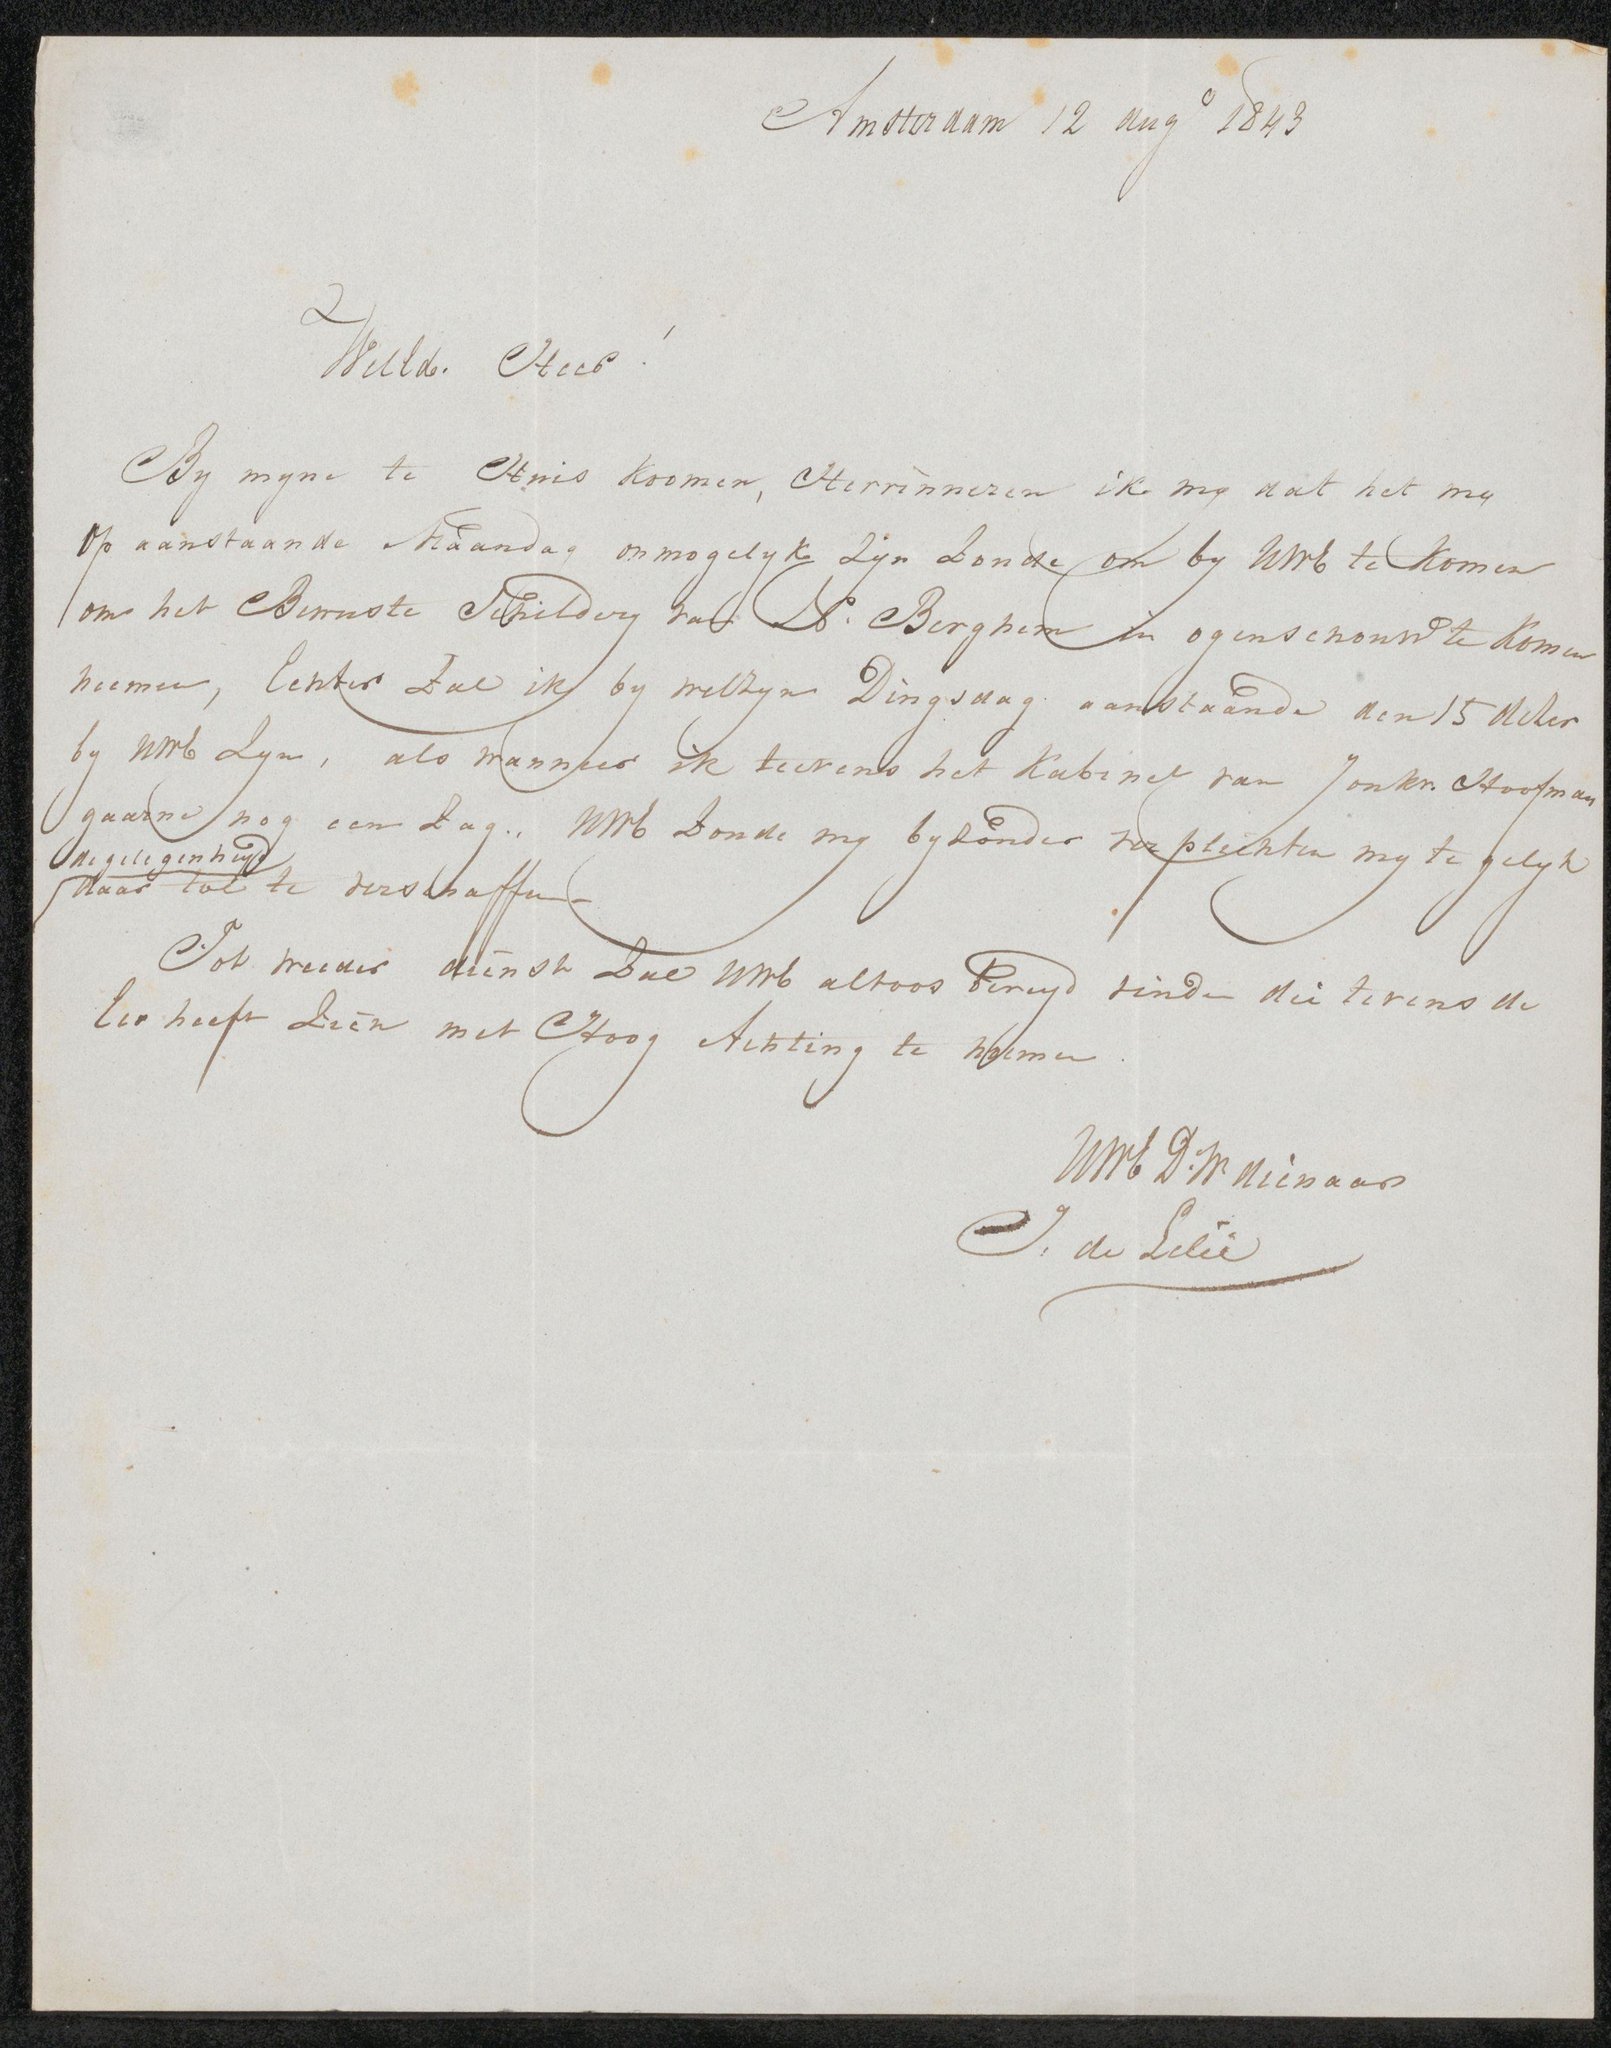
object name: letter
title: Brief aan anoniem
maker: jan adriaan antonie de lelie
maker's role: draughtsman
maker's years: 1788-1845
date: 1843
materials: ink, paper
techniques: pen, writing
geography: amsterdam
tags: haarlem, nicolaes pietersz berchem, painting (including book-illumination, miniature-painting)